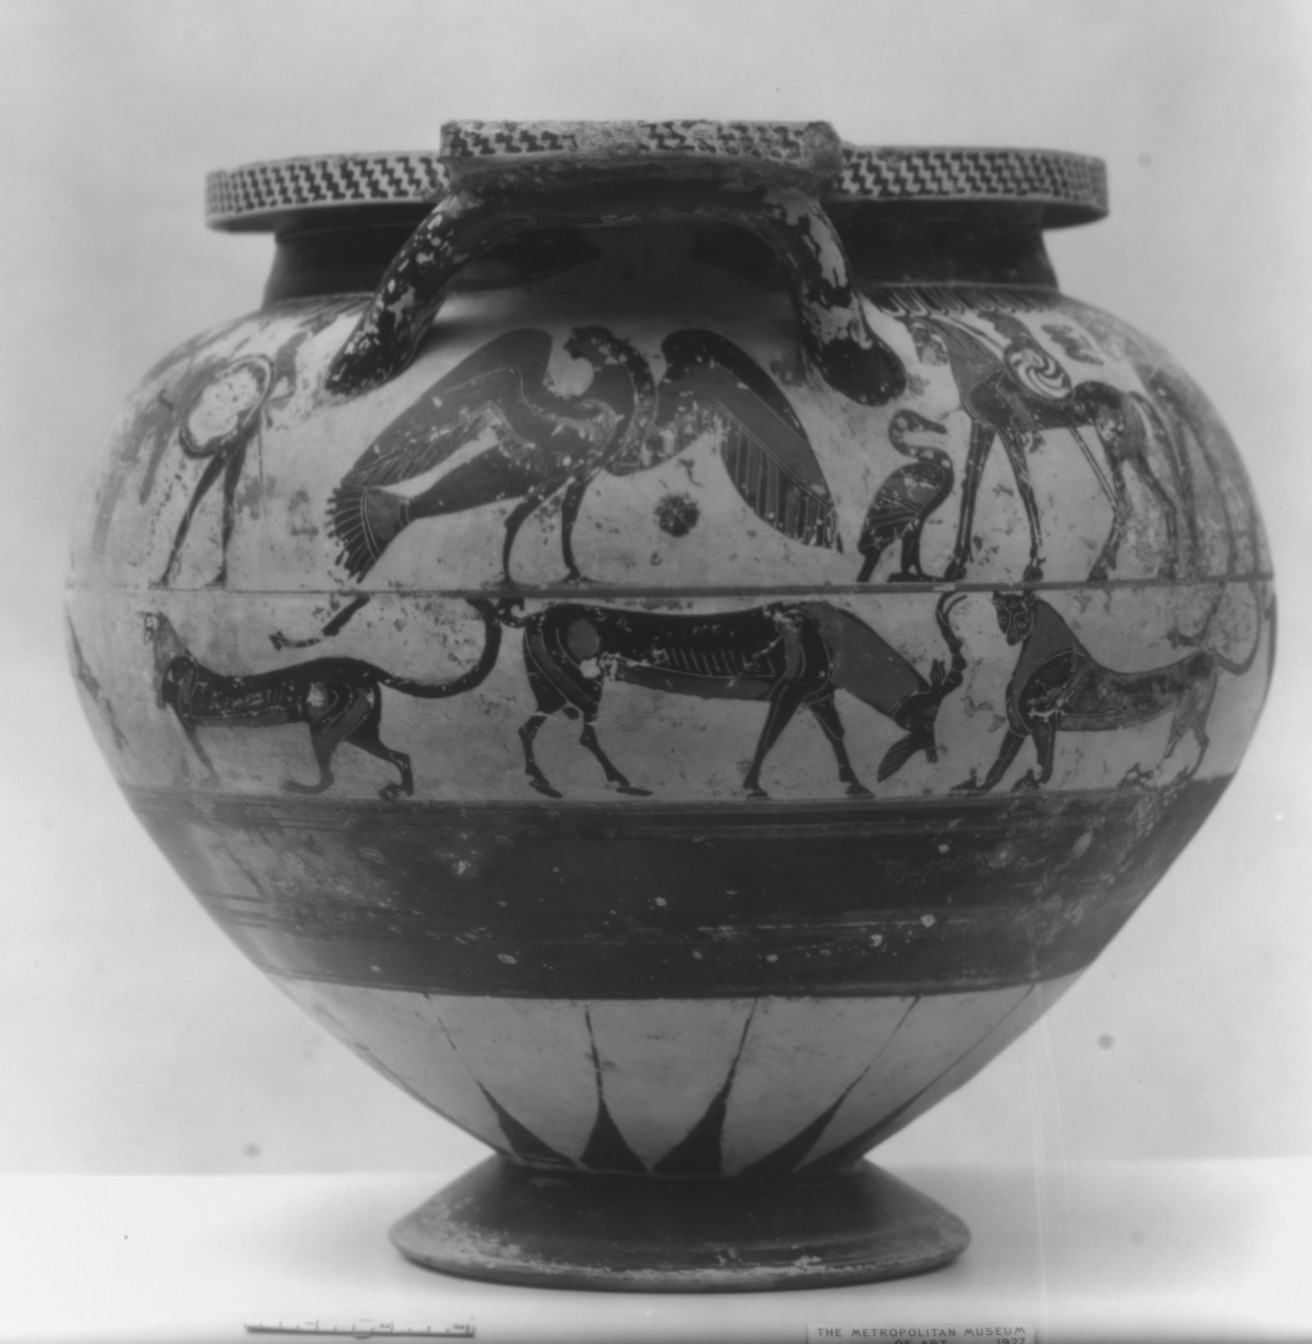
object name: column krater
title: Terracotta column-krater (bowl for mixing wine and water)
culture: greek, corinthian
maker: detroit painter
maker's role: artist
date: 590-570 BCE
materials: terracotta